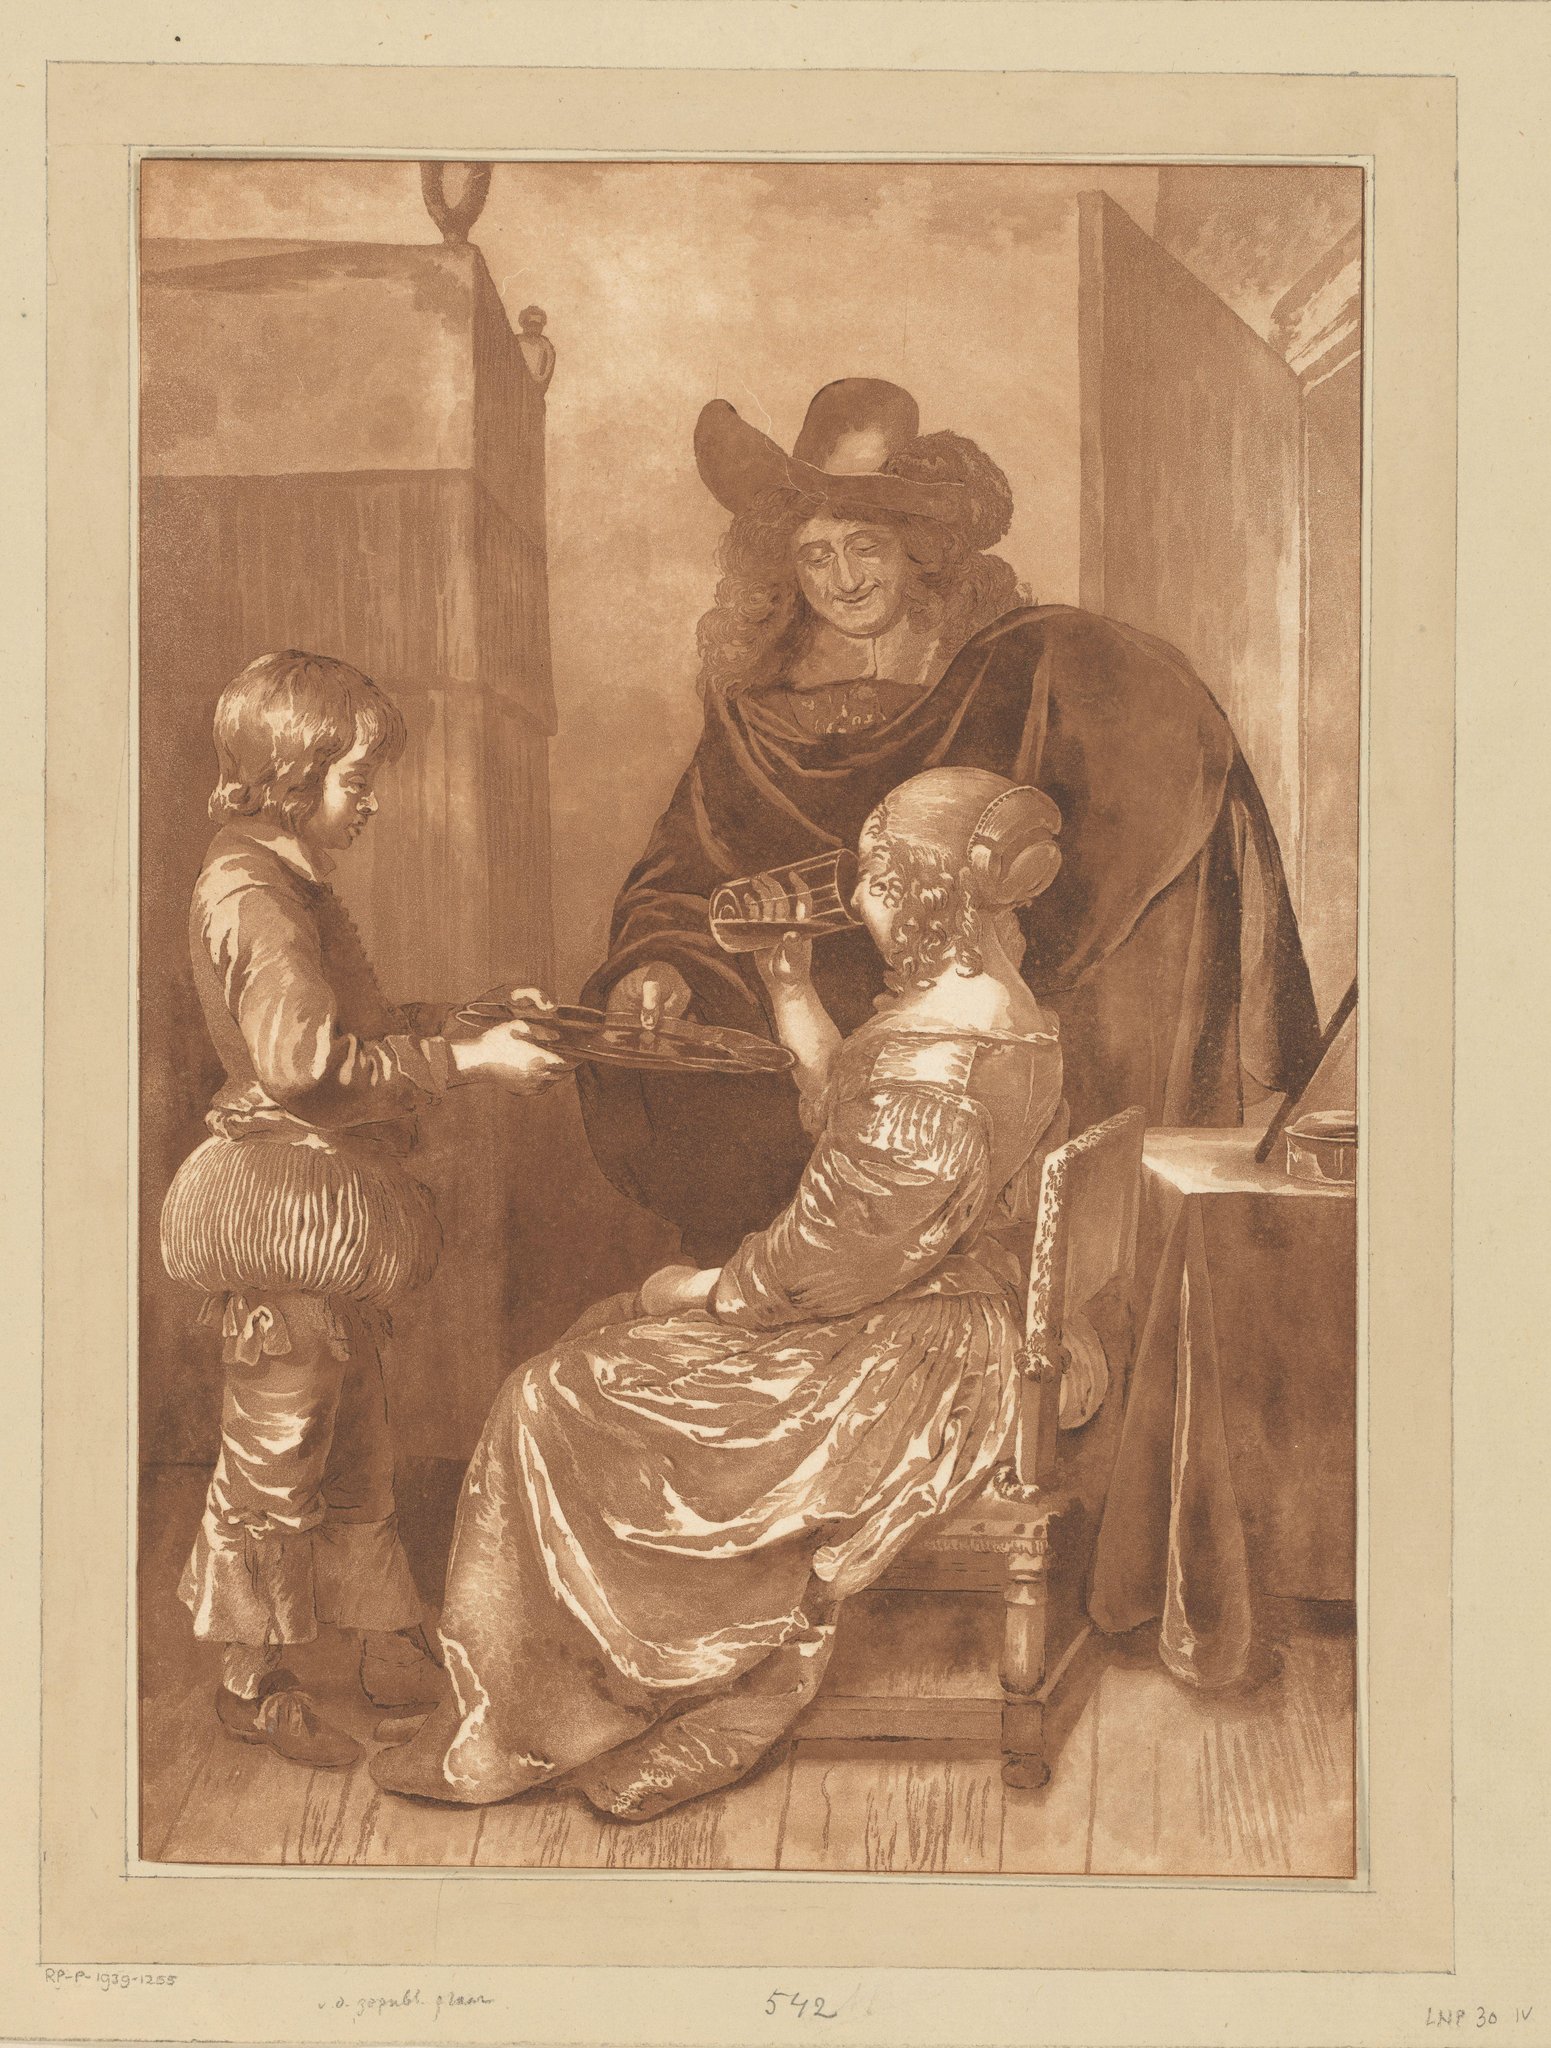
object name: print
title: Heer en dame met page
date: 1779-1781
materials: paper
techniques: etching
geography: amsterdam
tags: serving-dish, platter, glass, rummer, house personnel, servants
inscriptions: inscription: ‘Onafgemaakte Proef naar d' Tekening van G ter Burg’, collector's mark: ‘RIJKS / MUSM’, collector's mark: Lugt 2725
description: Een page presenteert een dienblad aan een dame en heer. De vrouw drinkt uit het glas. De prent ligt los in een album, zie blad 30.